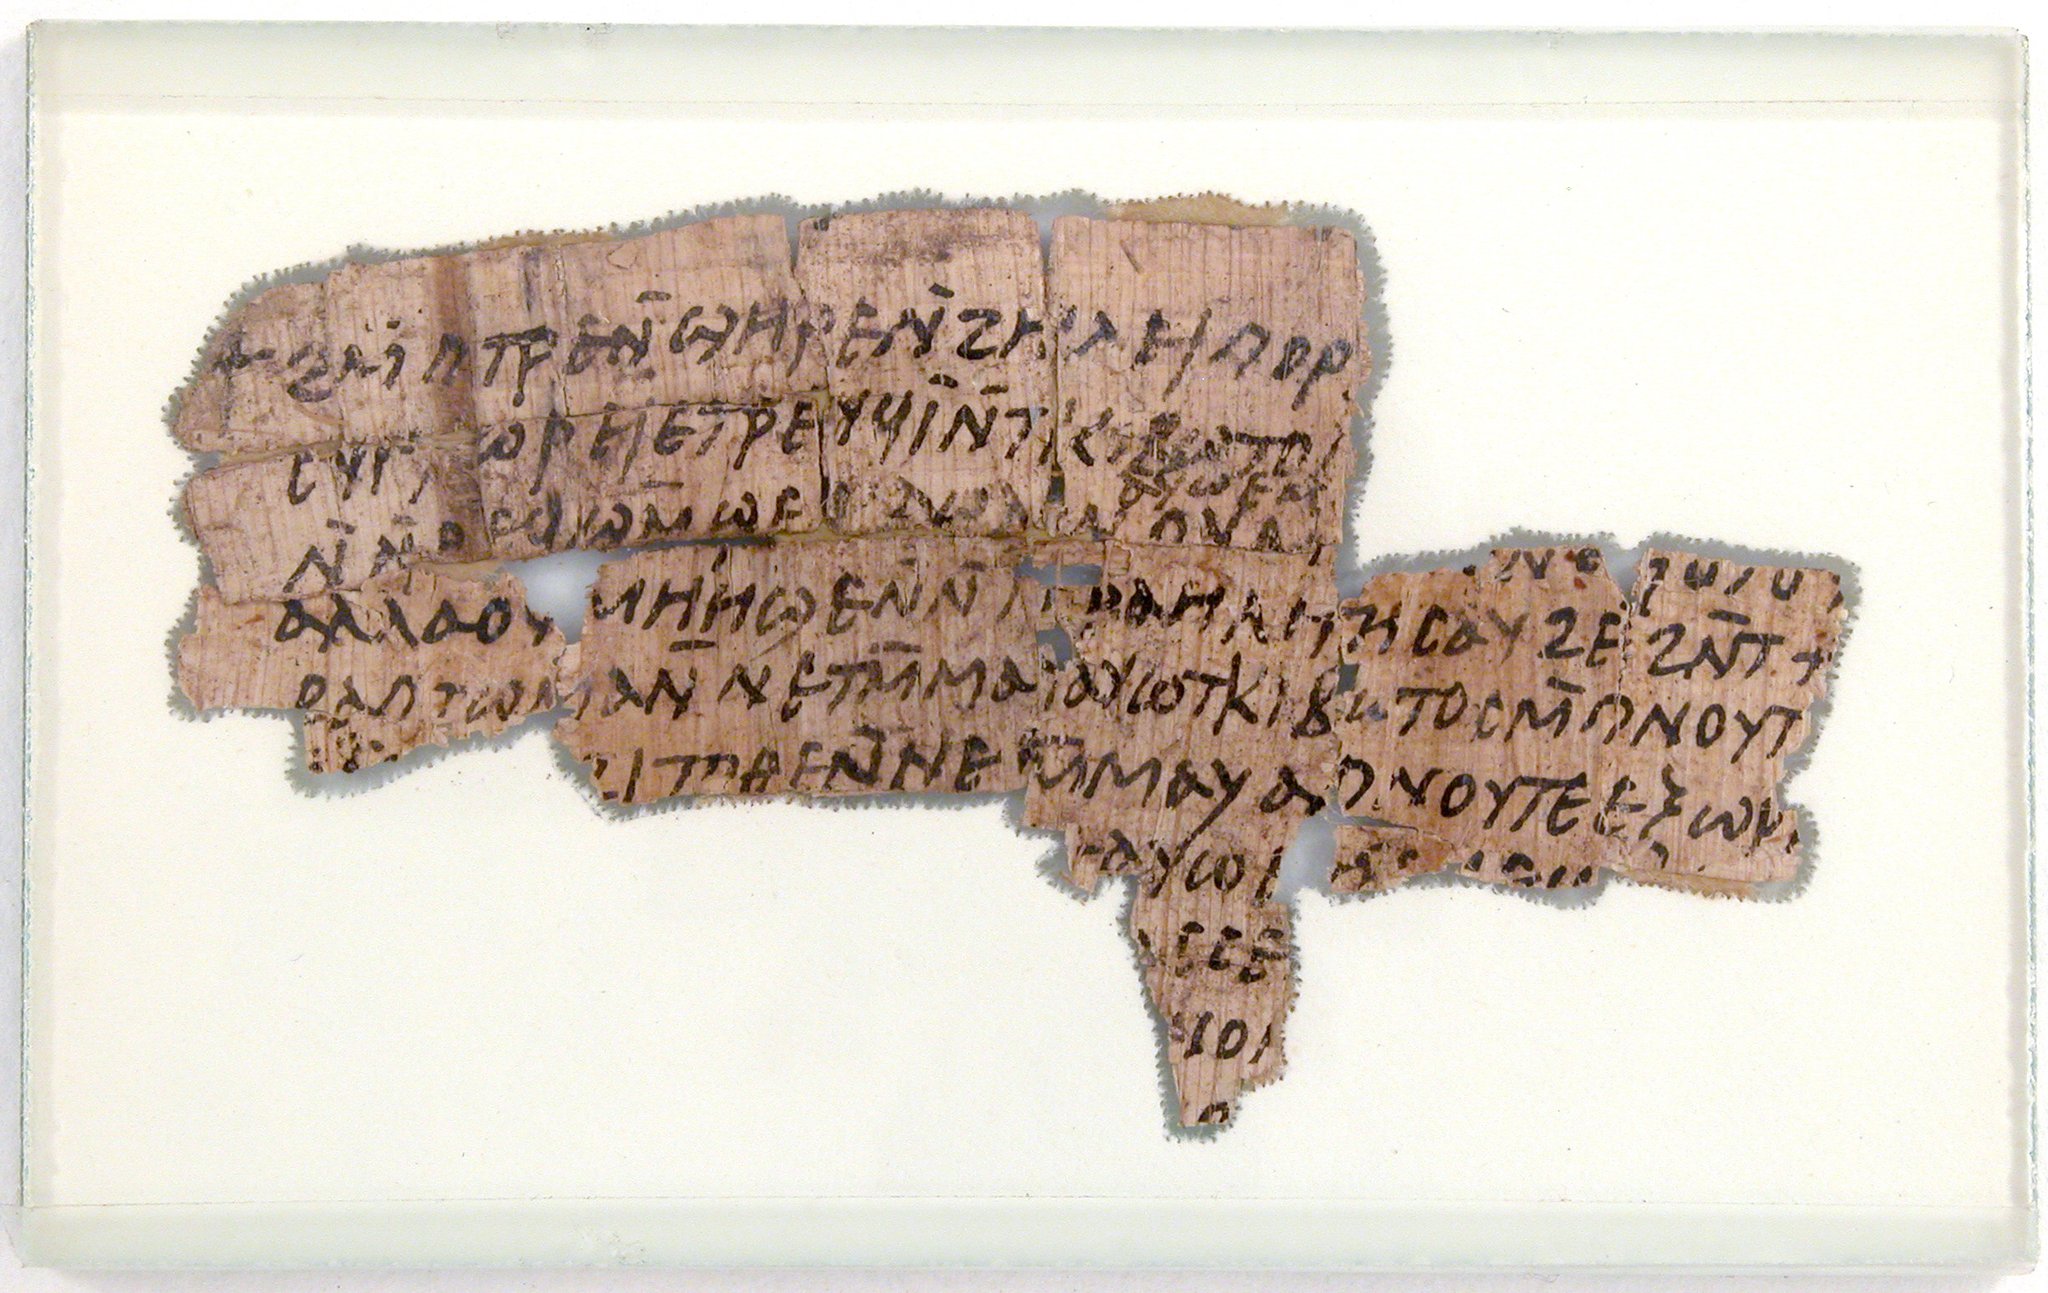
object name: fragment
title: Papyrus Fragment of a Letter from Pesenthius to Epiphanius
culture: coptic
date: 601-700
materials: ink, papyrus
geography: egypt